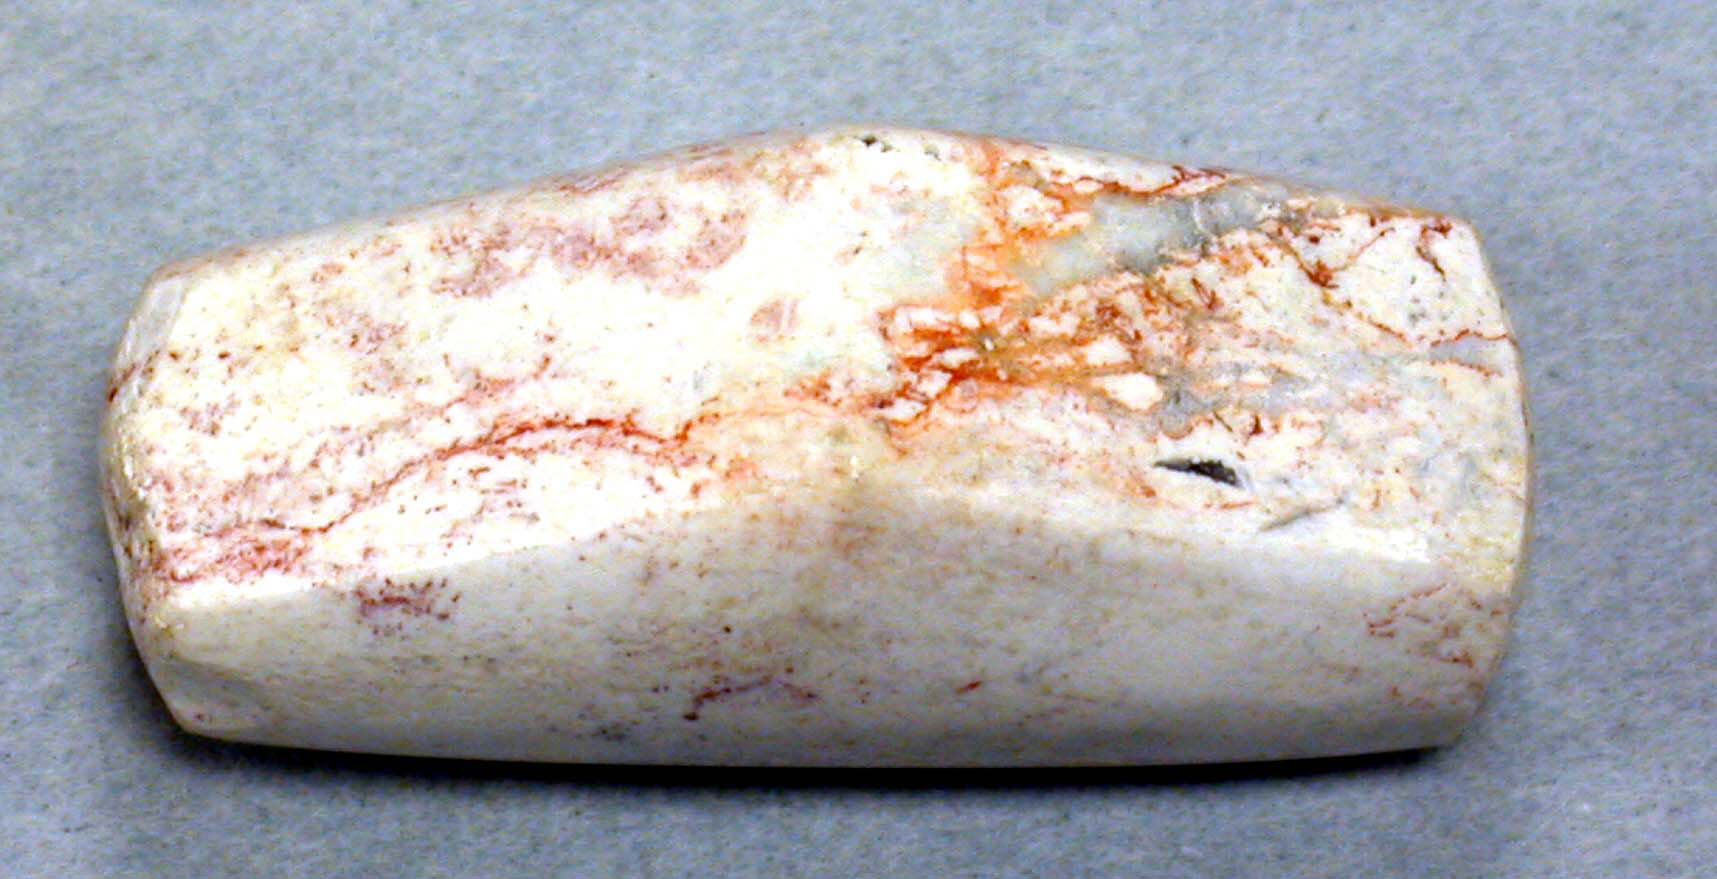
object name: ritual stone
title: Stone Pulidor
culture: mexican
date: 1501-1600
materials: stone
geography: mexico